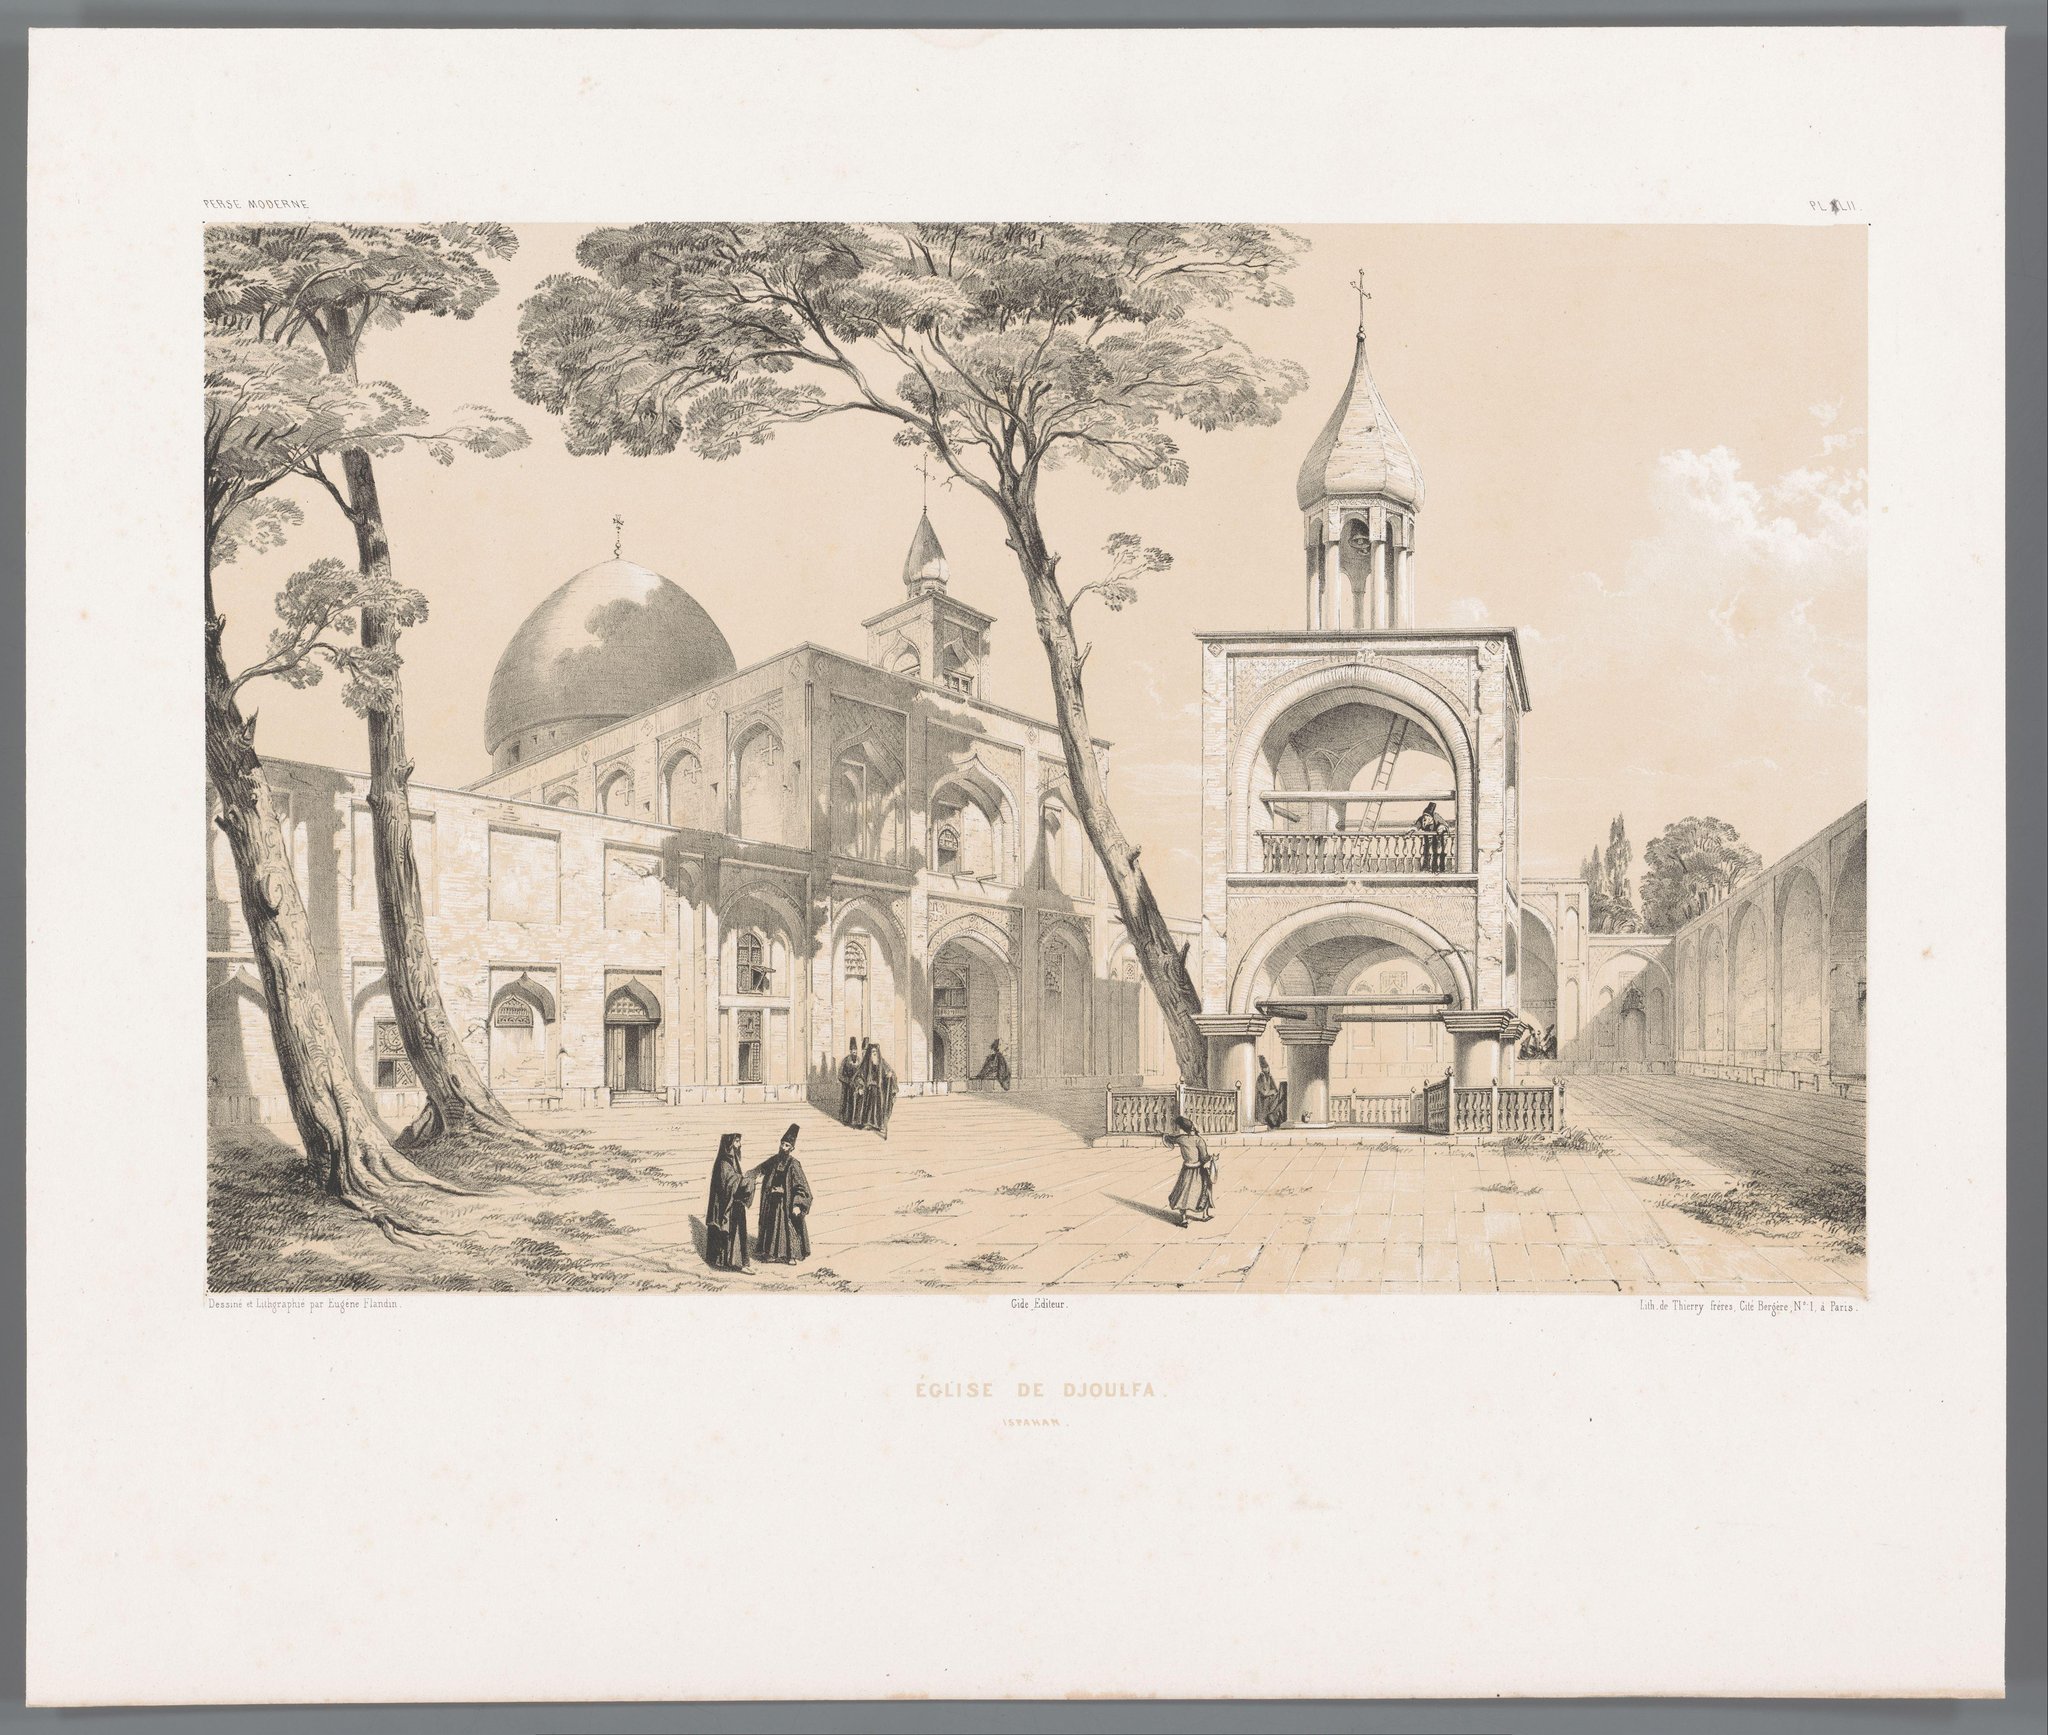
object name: print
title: Perse moderne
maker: eugène flandin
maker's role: painter, print maker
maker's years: 1809-1889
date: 1843-1854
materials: paper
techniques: tone lithography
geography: paris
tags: orthodox churches, church (exterior)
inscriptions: collector's mark: Lugt 2228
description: De officiële naam van de kathedraal is Heilige Verlosser Kathedraal. Uit: Coste, Pascal-Xavier en Eugène Napoléon Flandin. Voyage en Perse de mm. Eugène Flandin, peintre, et Pascal Coste, architecte (...). 8 dln. Parijs: Gide et Jules Baudry, 1843-1854.